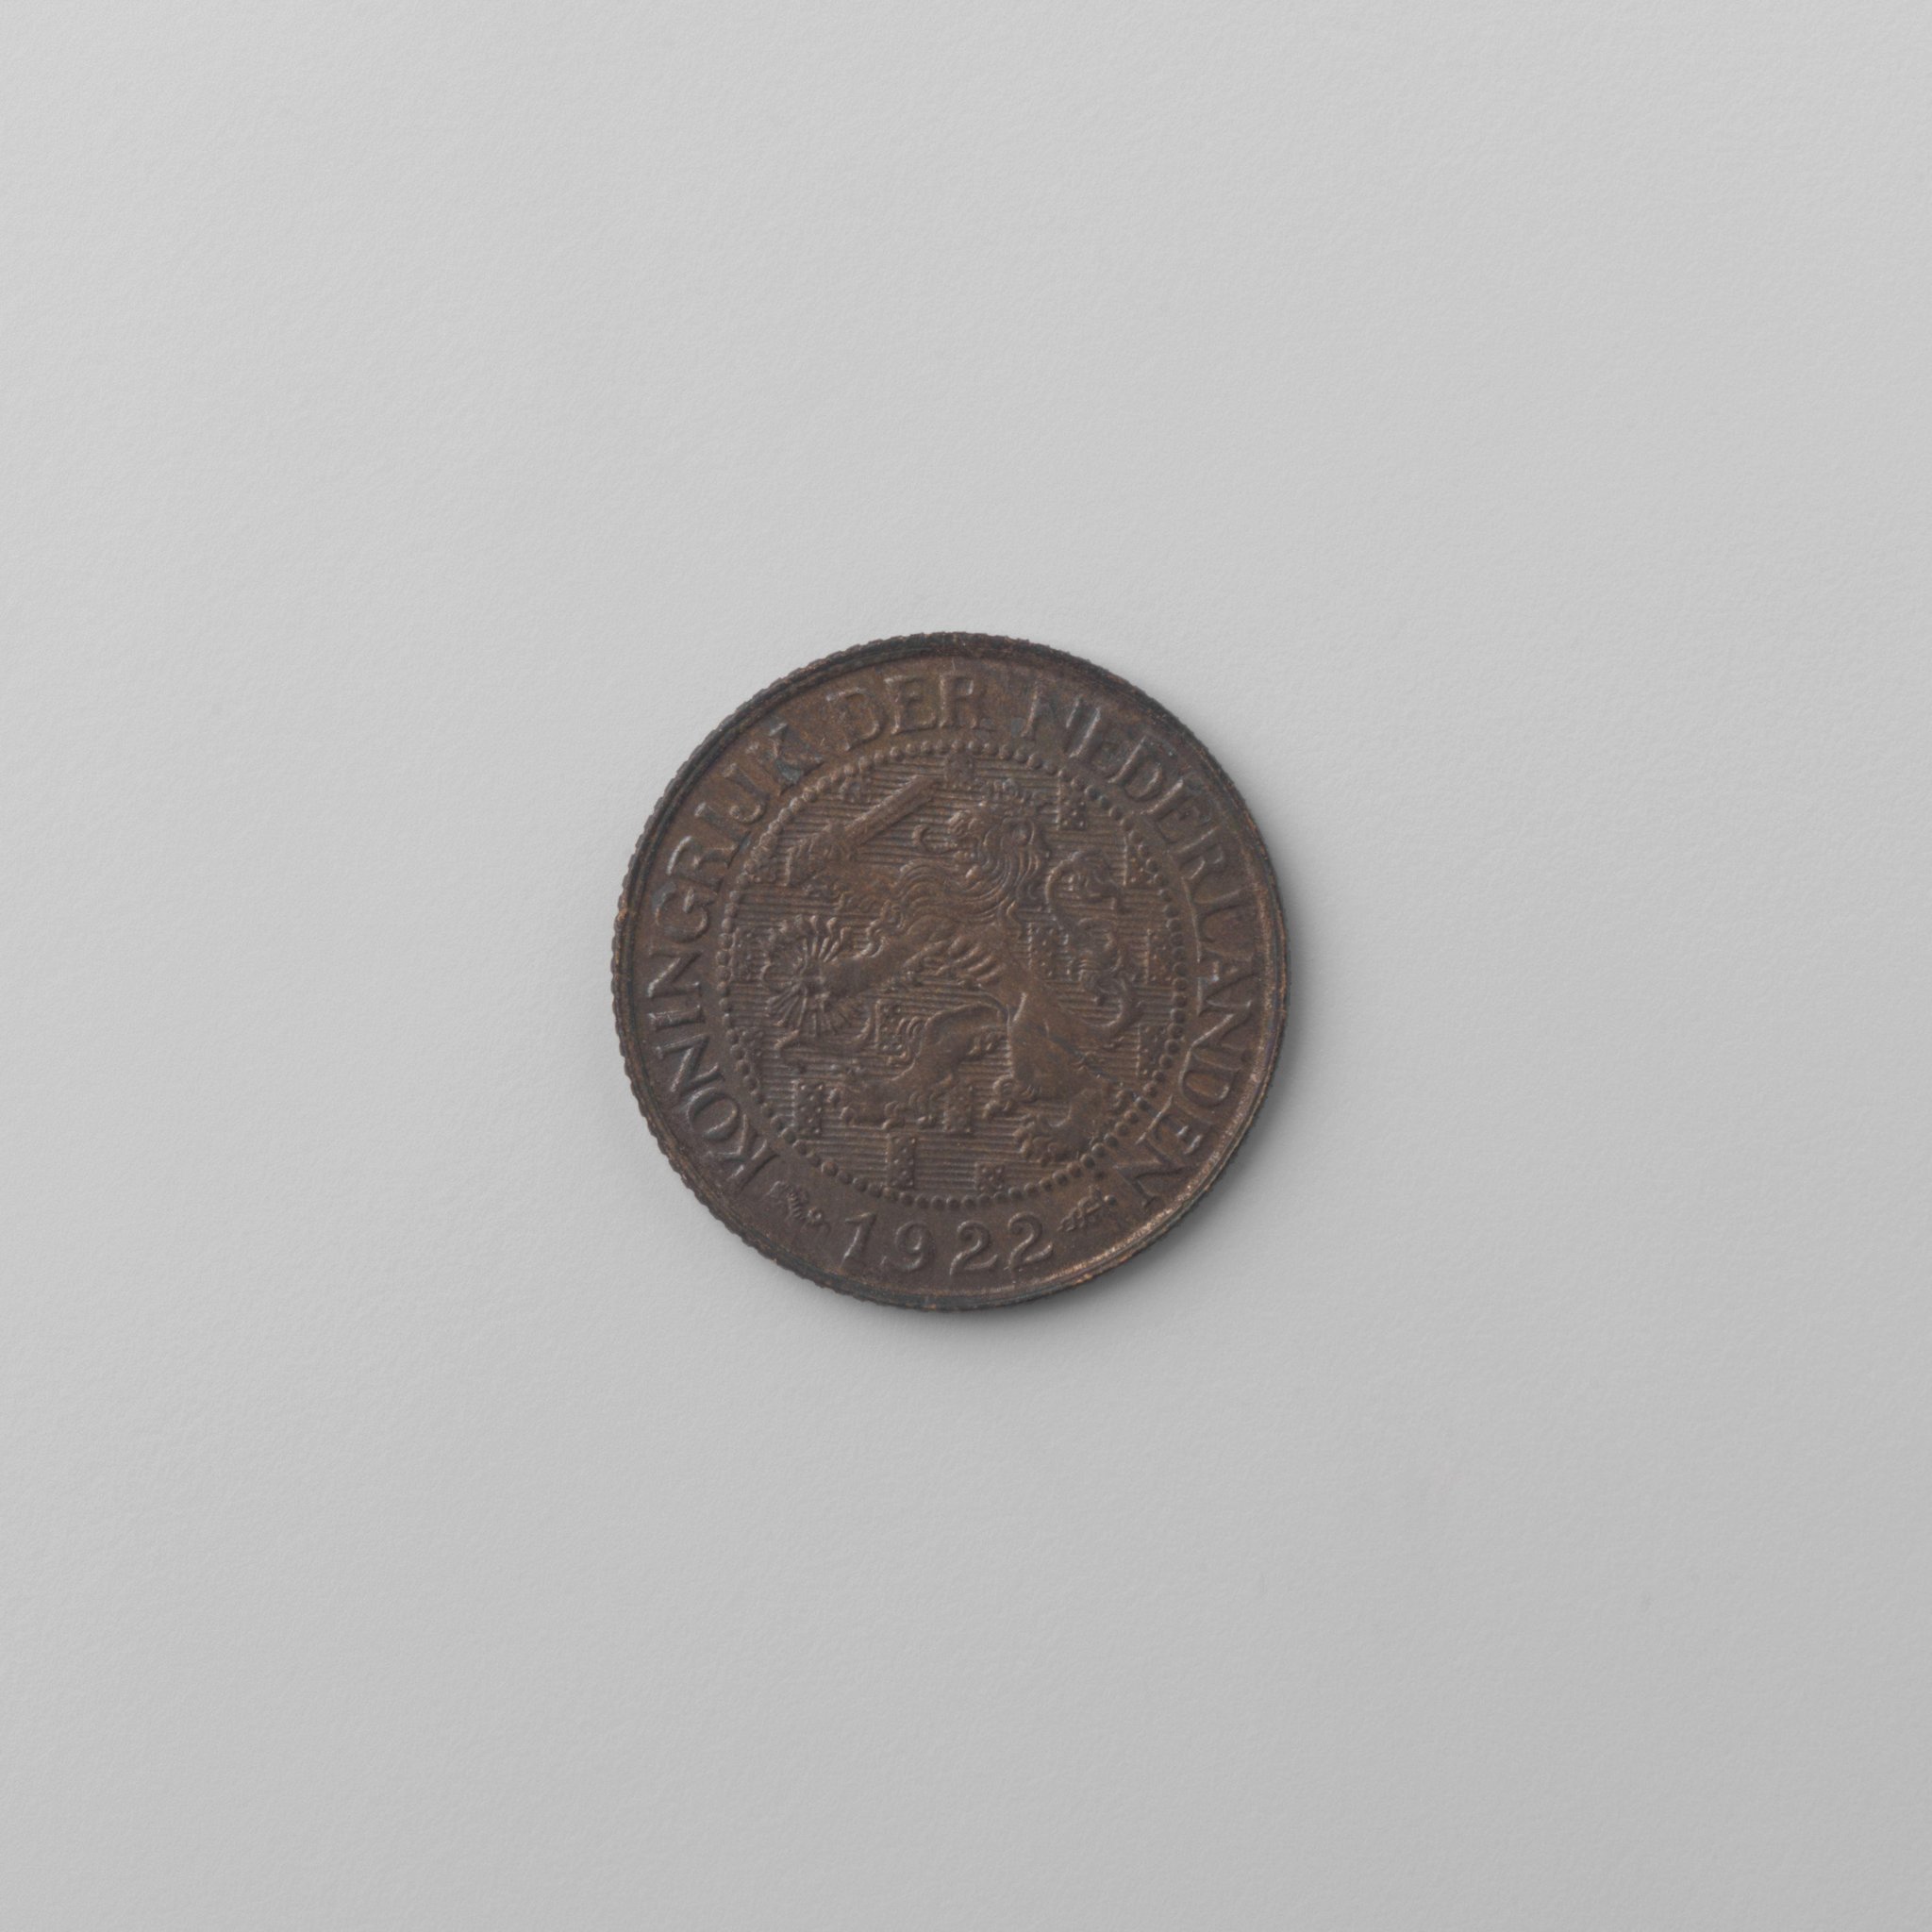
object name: cent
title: Nederlandse cent,1922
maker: wilhelmina of the netherlands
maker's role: print maker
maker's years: 1880-1962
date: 1922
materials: bronze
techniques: striking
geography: utrecht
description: Bronzen munt. Voorzijde: in een veld rijkswapen. Jaartal onderaan in omschrift. Keerzijde: binnen twee samengebonden oranjetakken waarde-aanduiding 1 cent. Kartelrand.